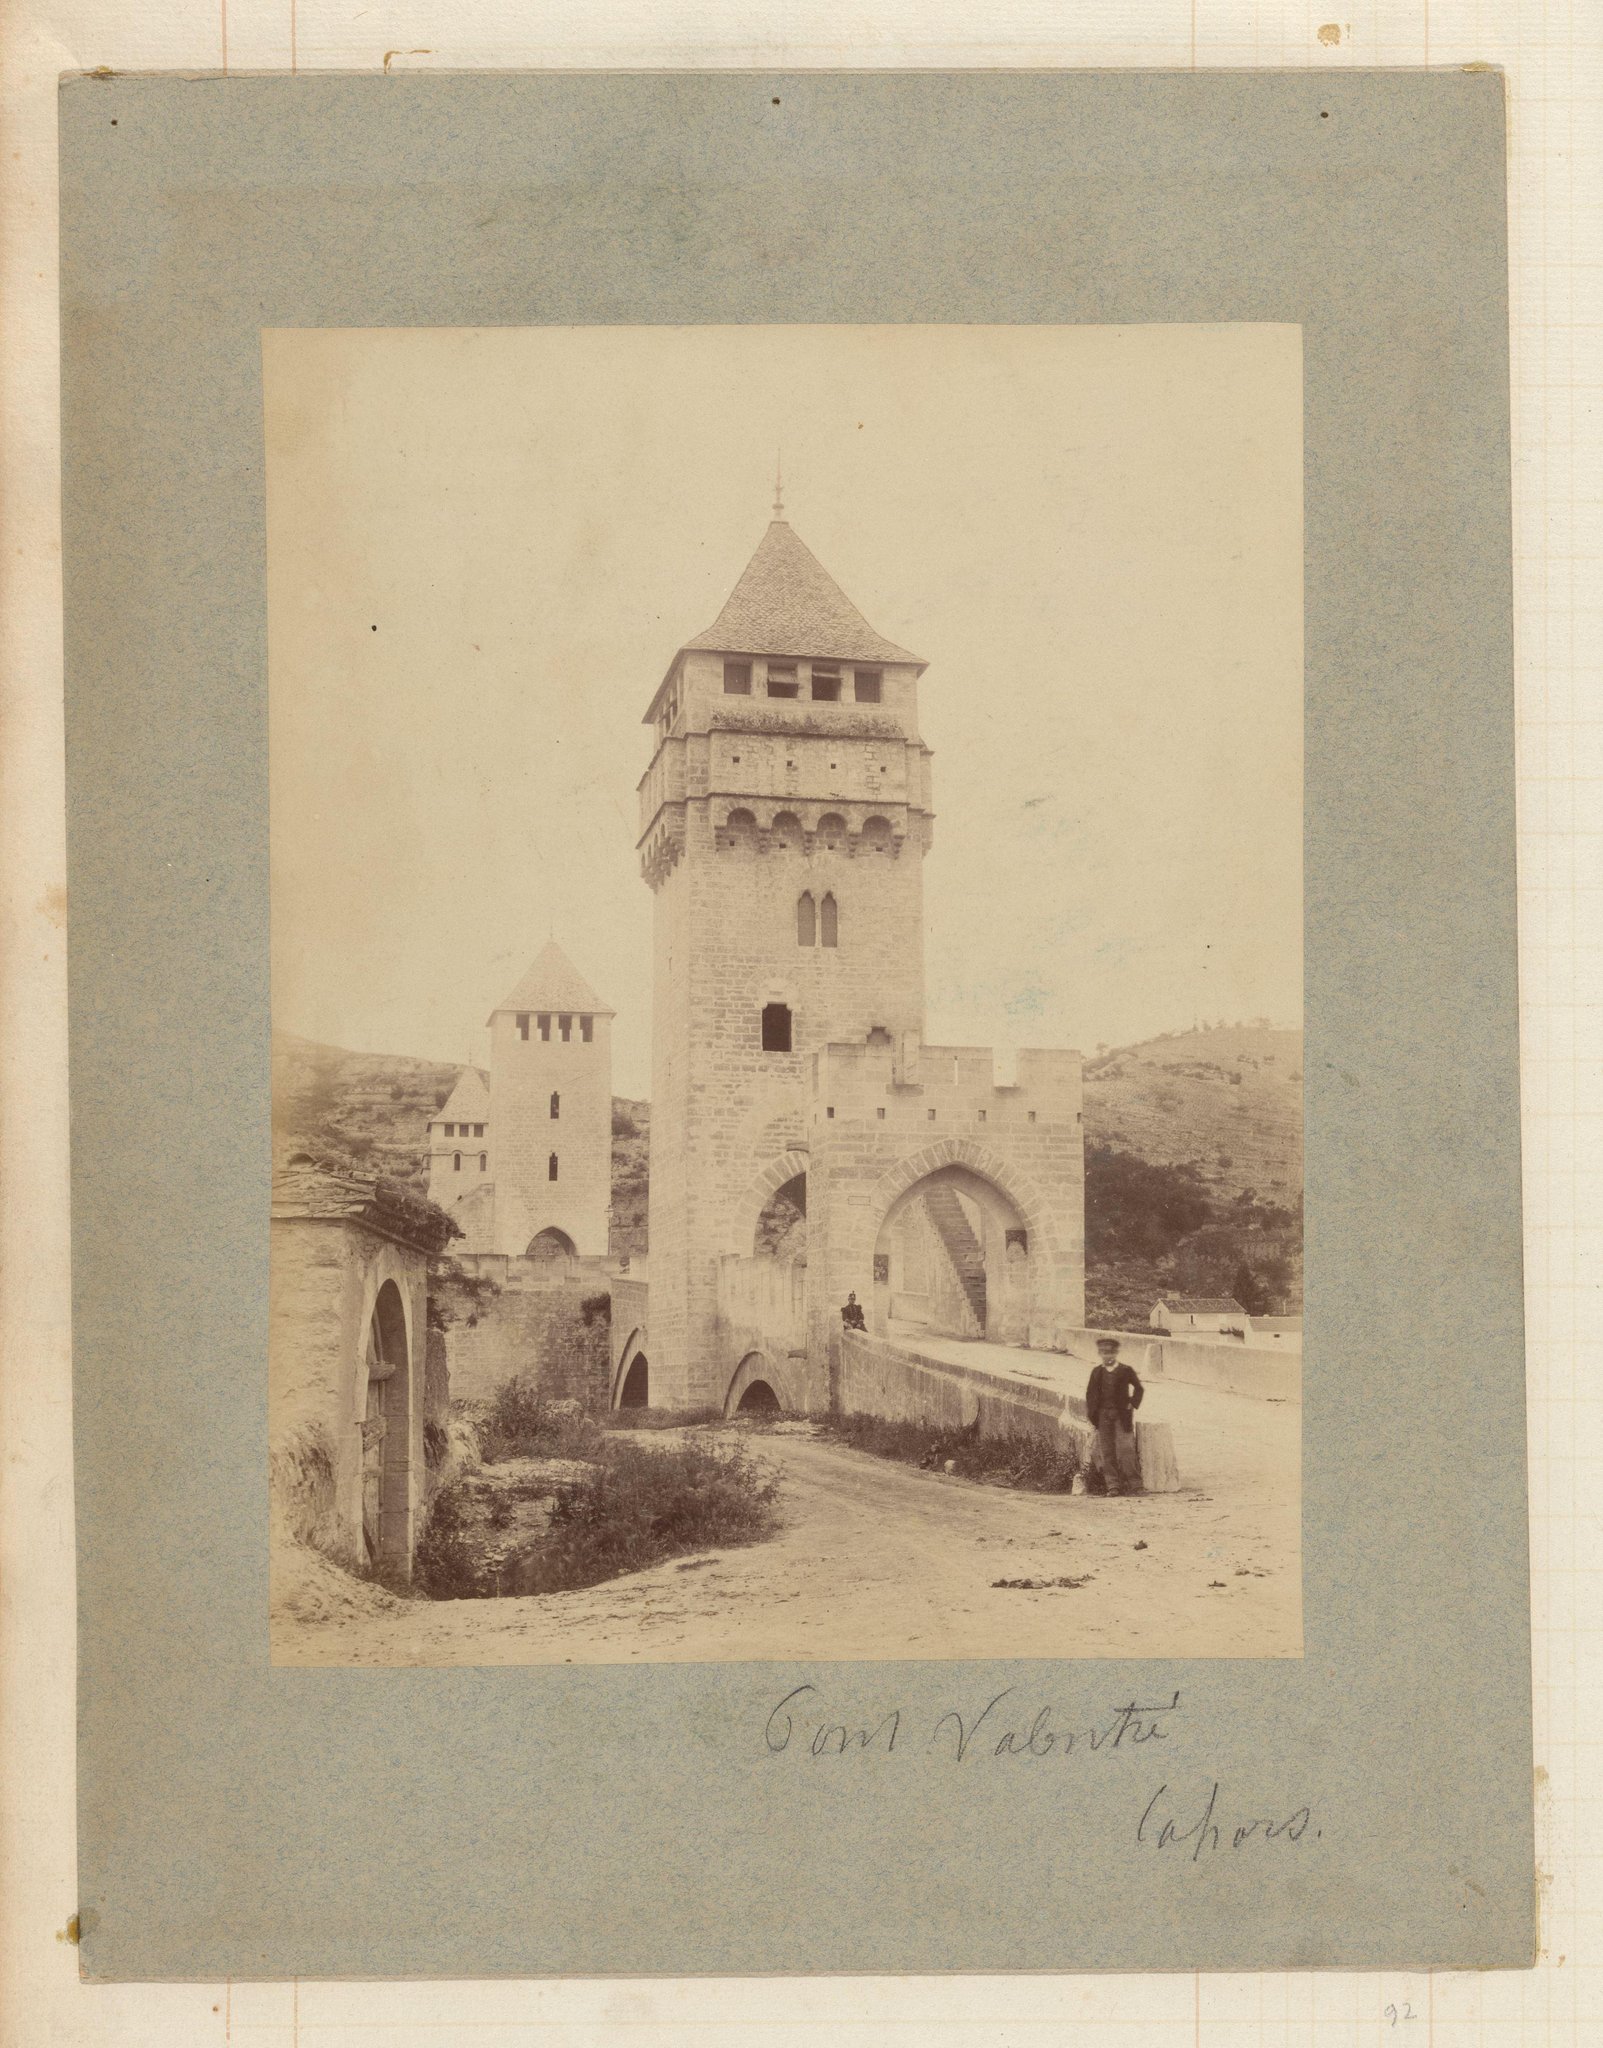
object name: photograph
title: Pont Valentré Cahors.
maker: Anonymous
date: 1880-1900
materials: cardboard, paper, photographic support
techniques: albumen print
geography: cahors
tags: towers ~ fortified city, landscape with bridge, viaduct or aqueduct